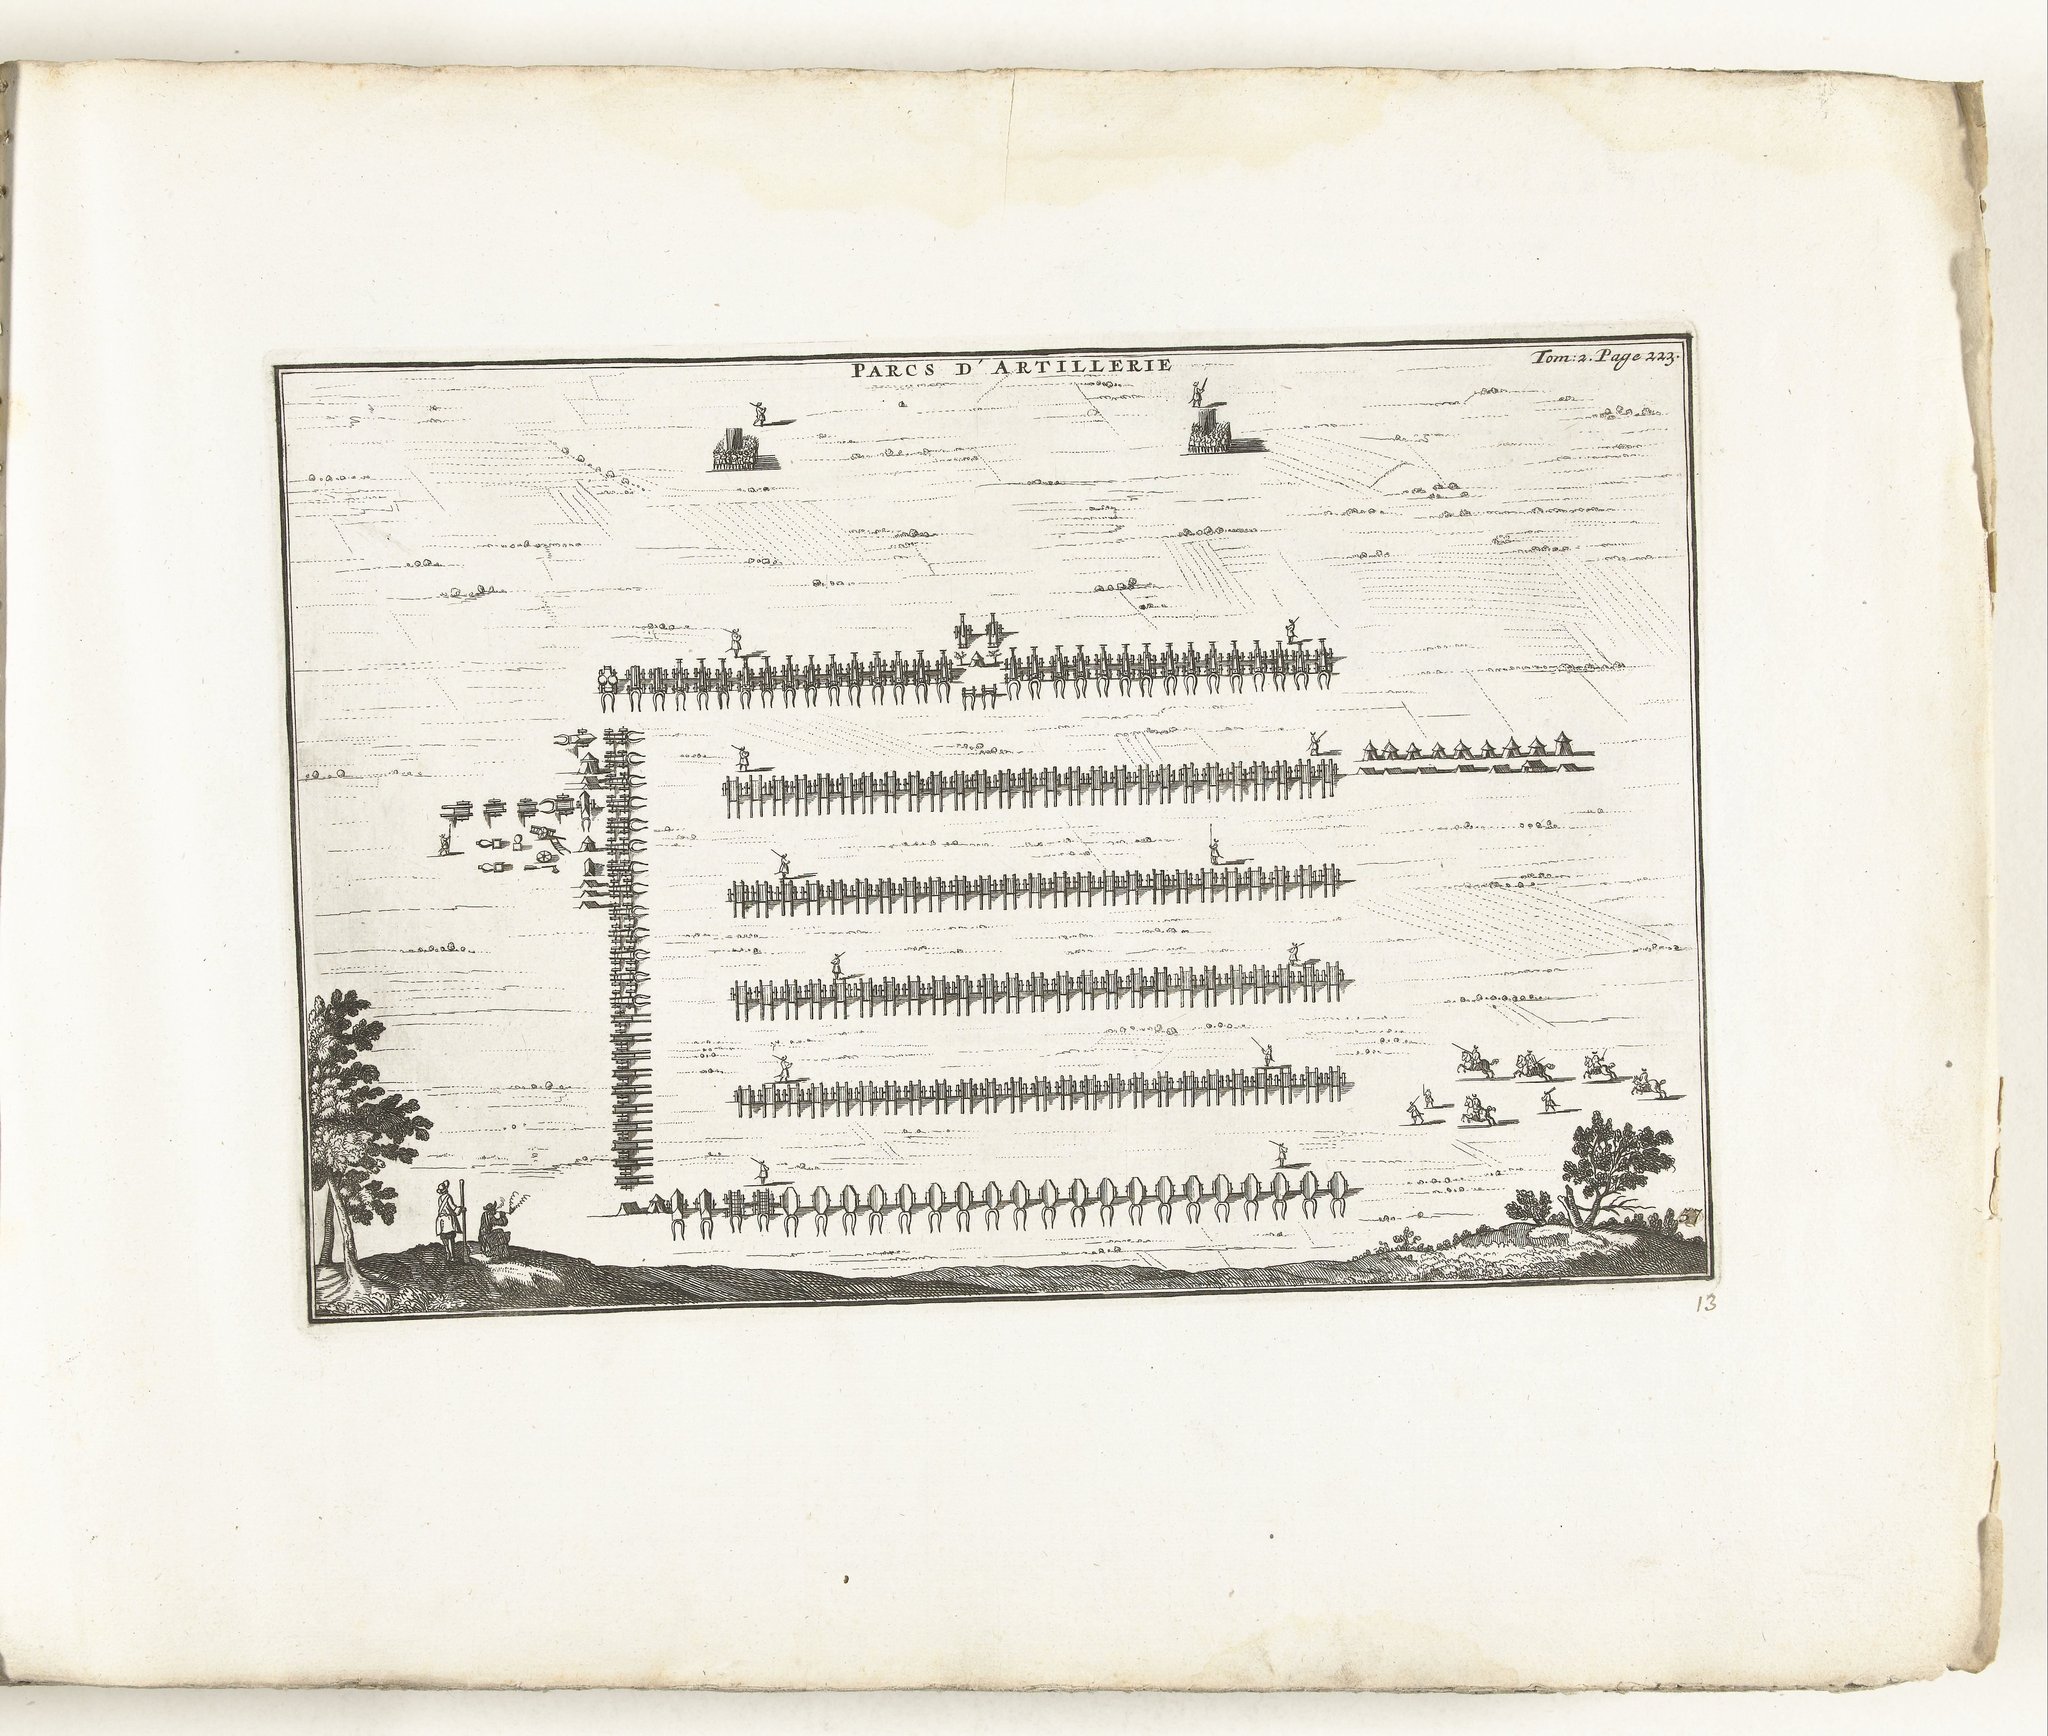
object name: print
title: Les Forces de l'Europe, Asie, Afrique et Amerique, ou description des principales villes avec leurs fortifications. Dessignées par les meilleurs ingenieurs, particulierement celles qui sont sous la domination de la France (...) et ornées de plusieurs superbes edifices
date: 1702-1703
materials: paper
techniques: etching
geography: amsterdam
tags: battle arrays (+ artillery)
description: Schematische voorstelling van de correcte opstelling van artillerie. Gemerkt rechtsboven: Tom: 2. Pag 223 en rechtsonder: 57. Plaat nr. 13 in het prentwerk bestaande in totaal uit 276 genummerde platen van vermaarde sterke steden en vestingen in het kader van de Spaanse Successieoorlog. Voor het merendeel zijn deze platen gekopieerd naar de anonieme Franse platen: in Les forces de l'Europe en in: Le theatre de la guerre, dans les Pays-Bas, beide oorspronkelijk uitgegeven door Nicolas de Fer te Parijs (1693-1697) in het kader van de Negenjarige Oorlog. Titel en opschriften in het Frans.